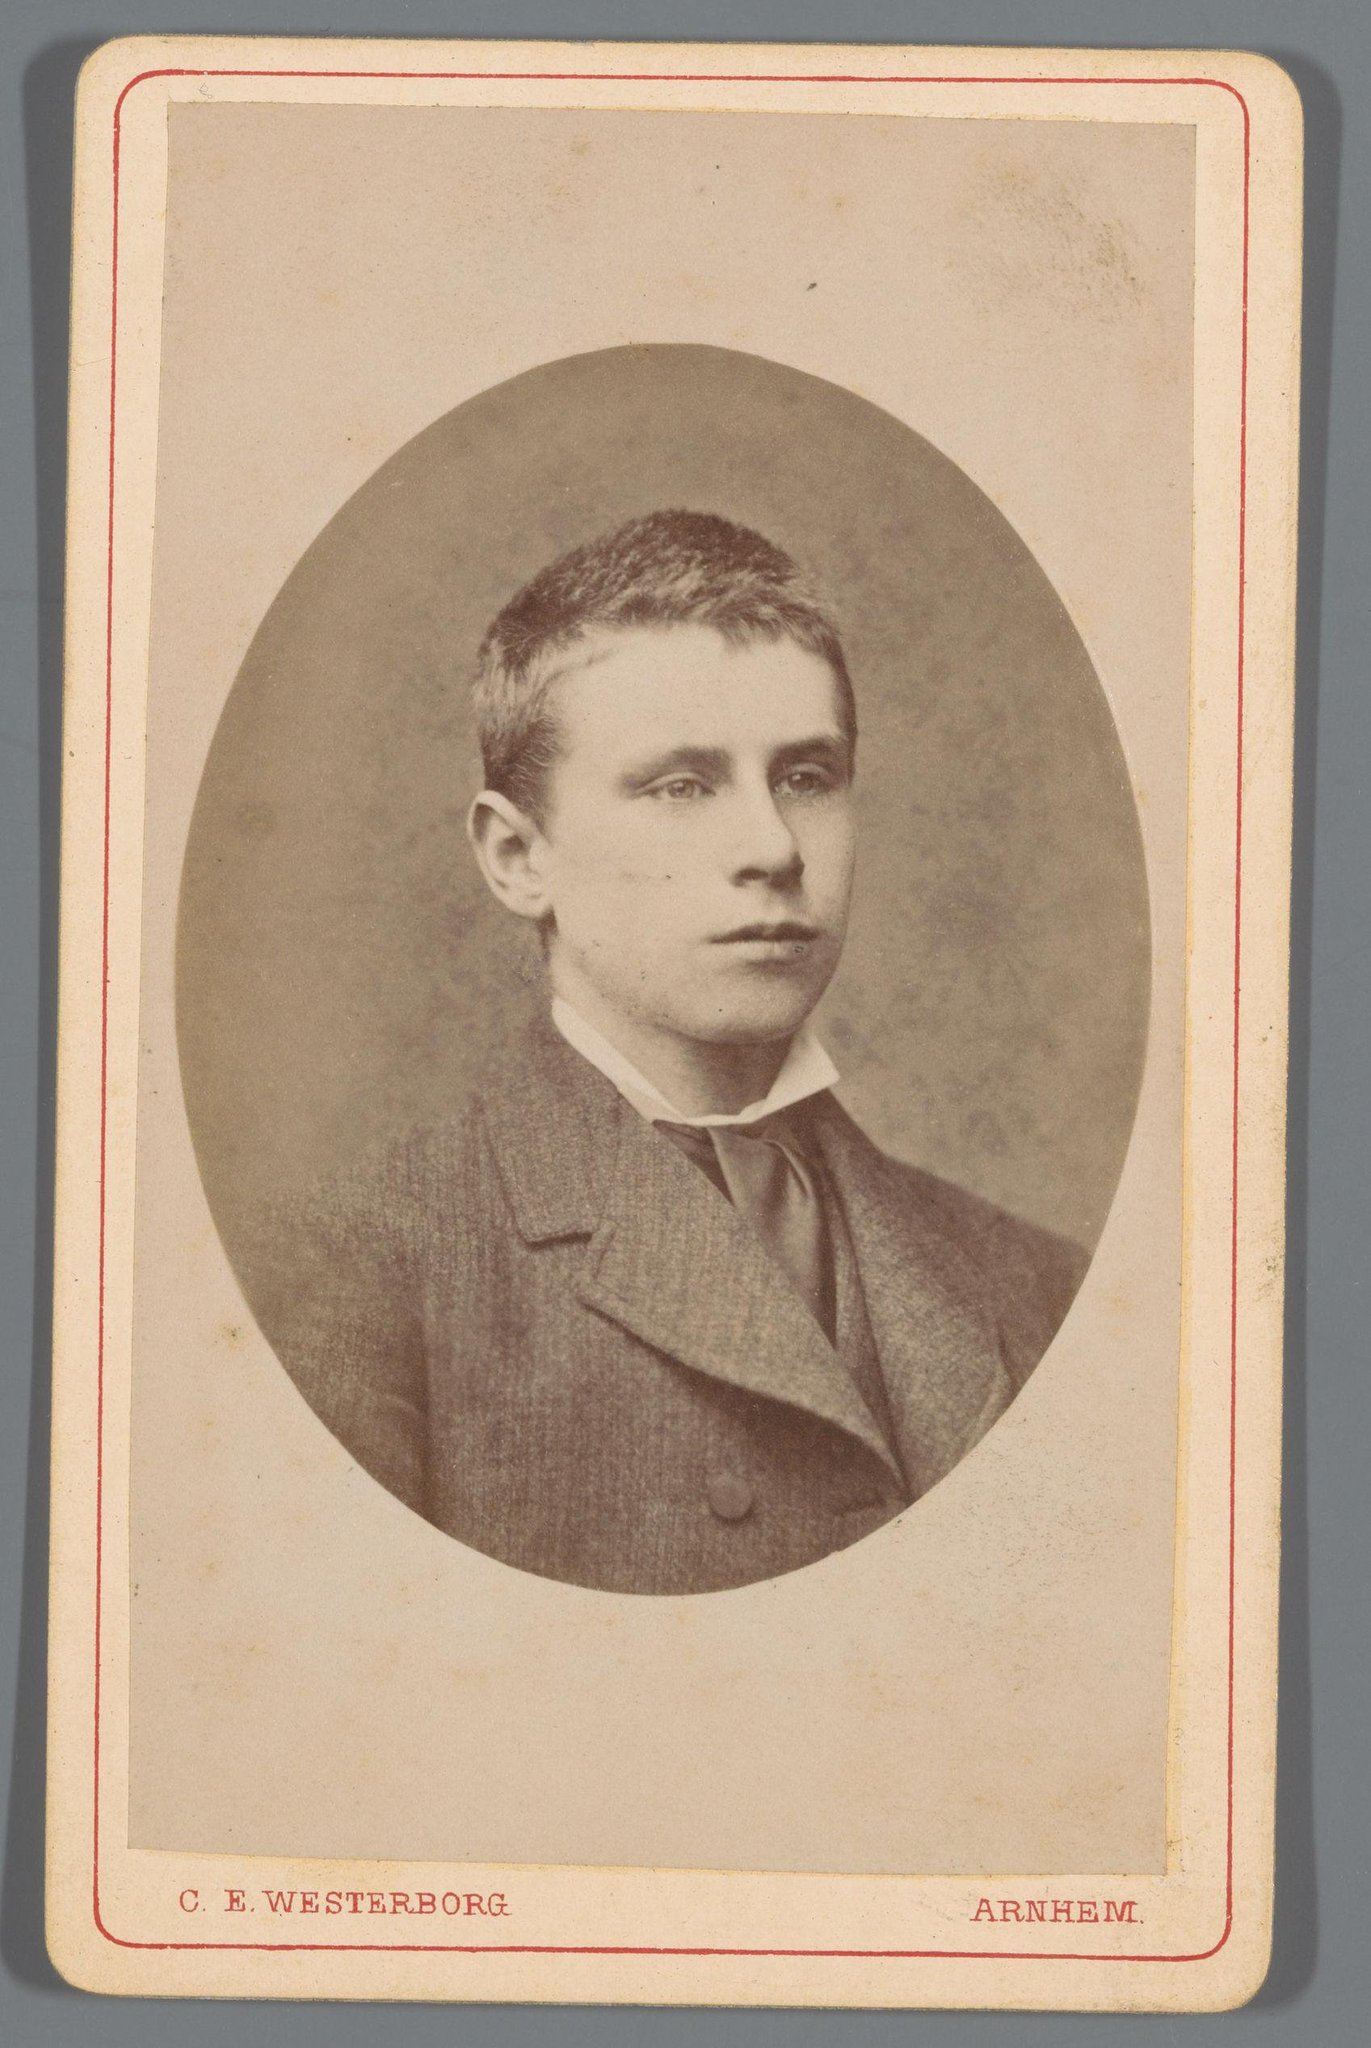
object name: photograph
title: Portret van een onbekende jongeman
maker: carel eduard westerborg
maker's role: fotograaf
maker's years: 1842-1916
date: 1861-1915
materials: cardboard, paper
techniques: albumen print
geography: arnhem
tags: youth, adolescent, anonymous historical person portrayed, arnhem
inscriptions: inscription: ‘C.E. Westerborg Arnhem.’, inscription: ‘Atelier/ van/ C.E. Westerborg/ Photograaf/ Arnhem/ Voor nabestelling worden alle/ negatieven bewaard.’